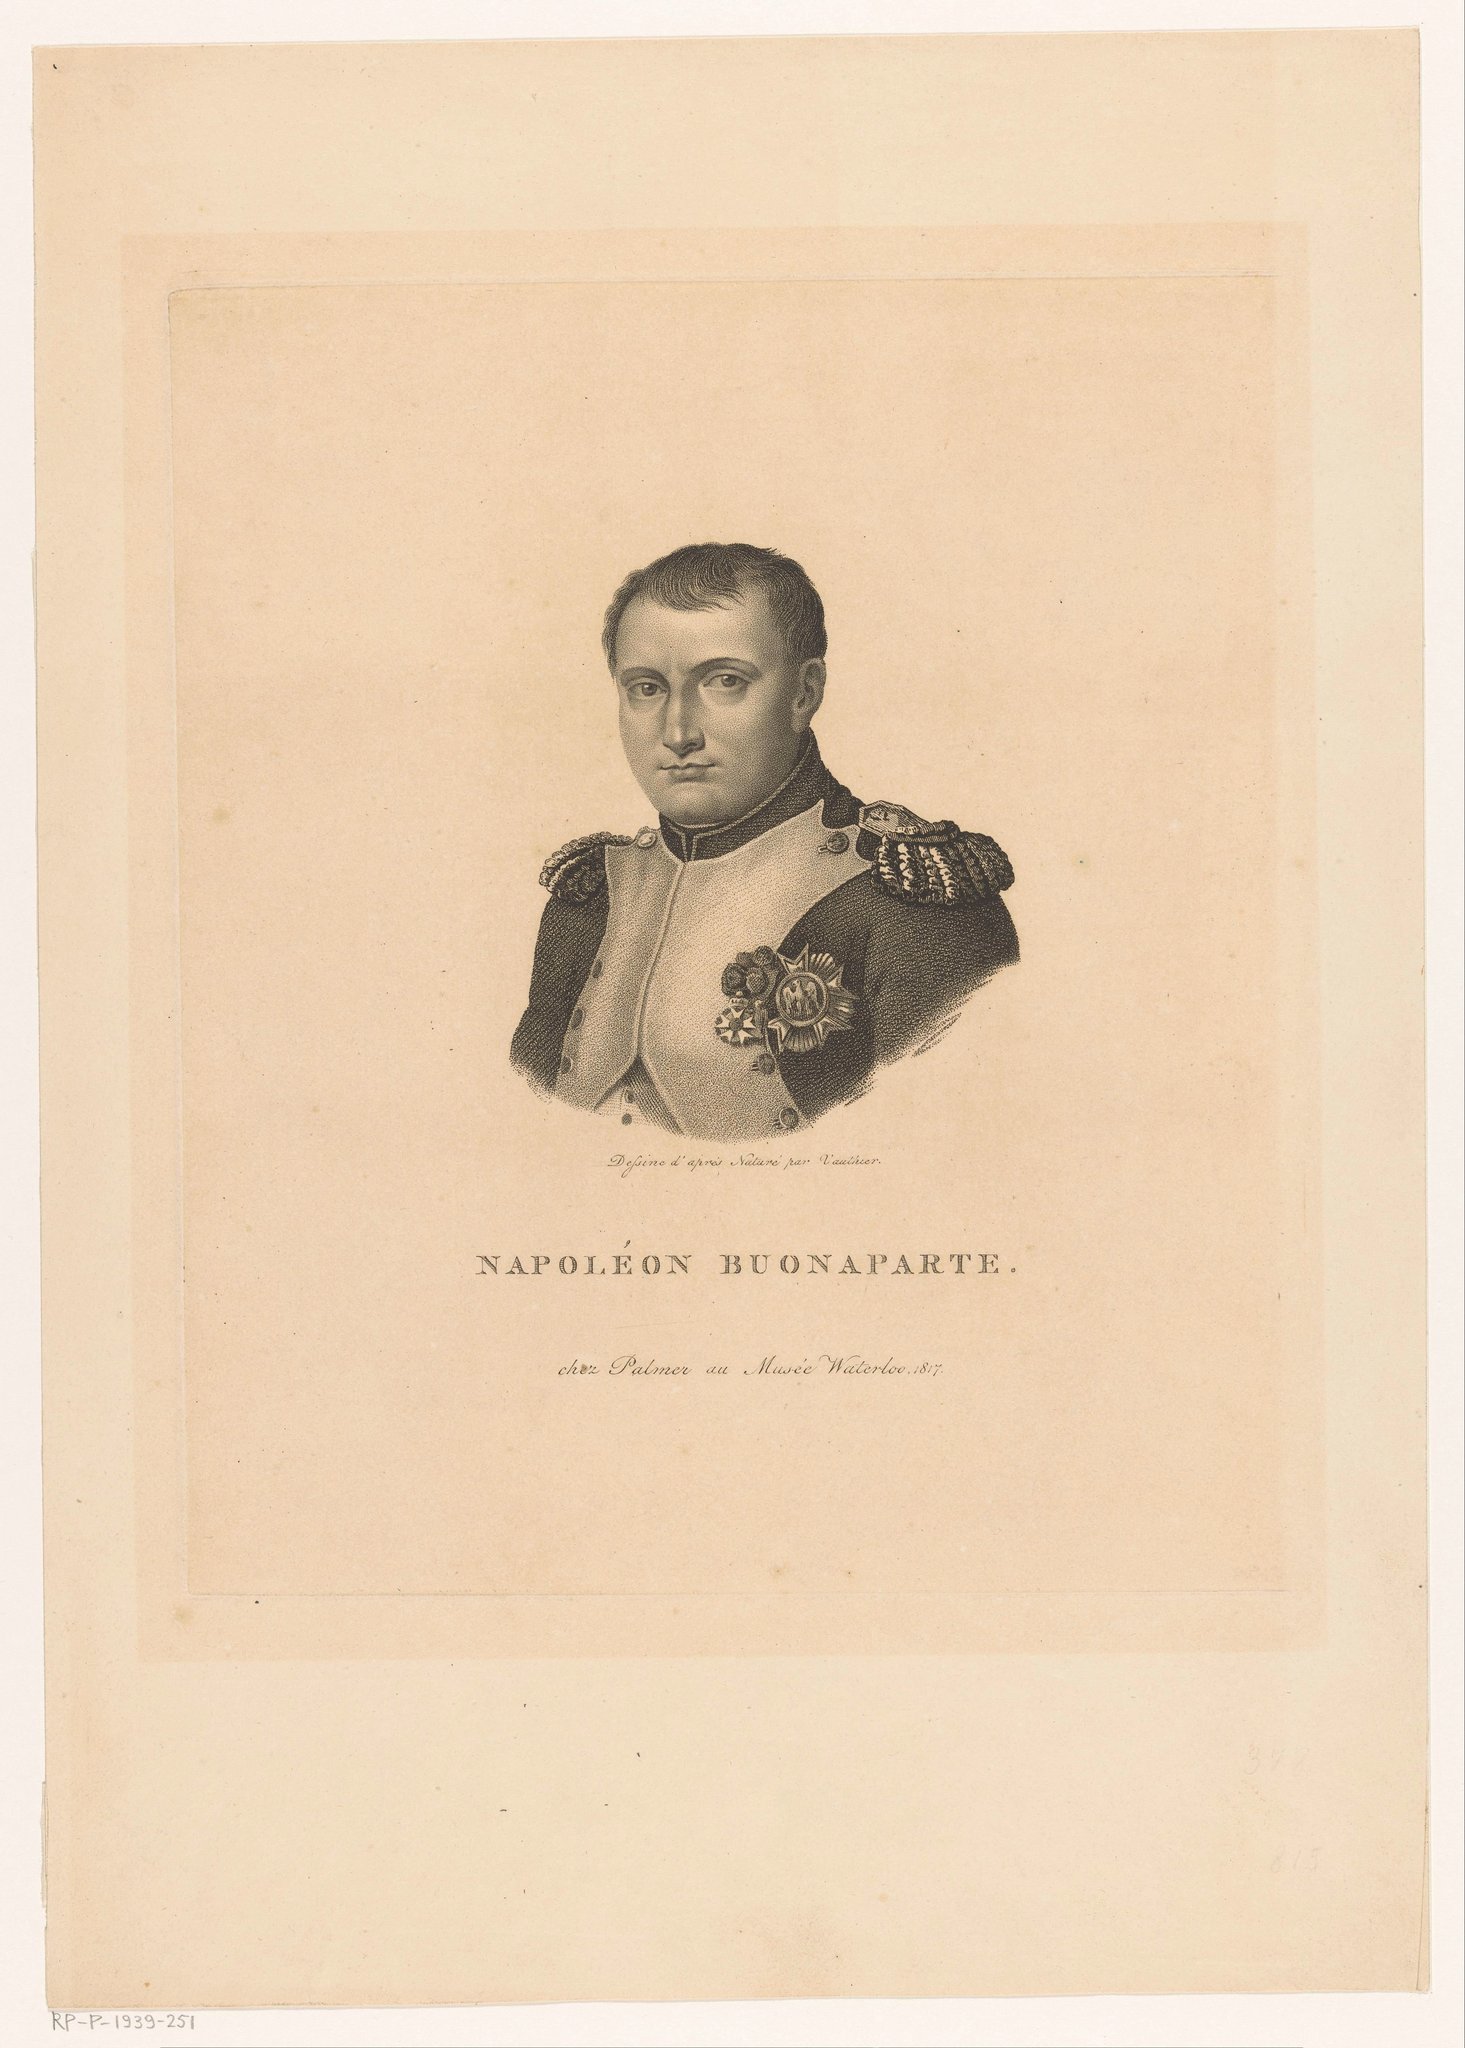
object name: print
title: Portret van Napoleon I Bonaparte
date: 1817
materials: paper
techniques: engraving, etching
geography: france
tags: napoleon i (emperor of the french), historical persons, medals and other marks of military honour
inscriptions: collector's mark: Lugt 2760, collector's mark: Lugt 2228